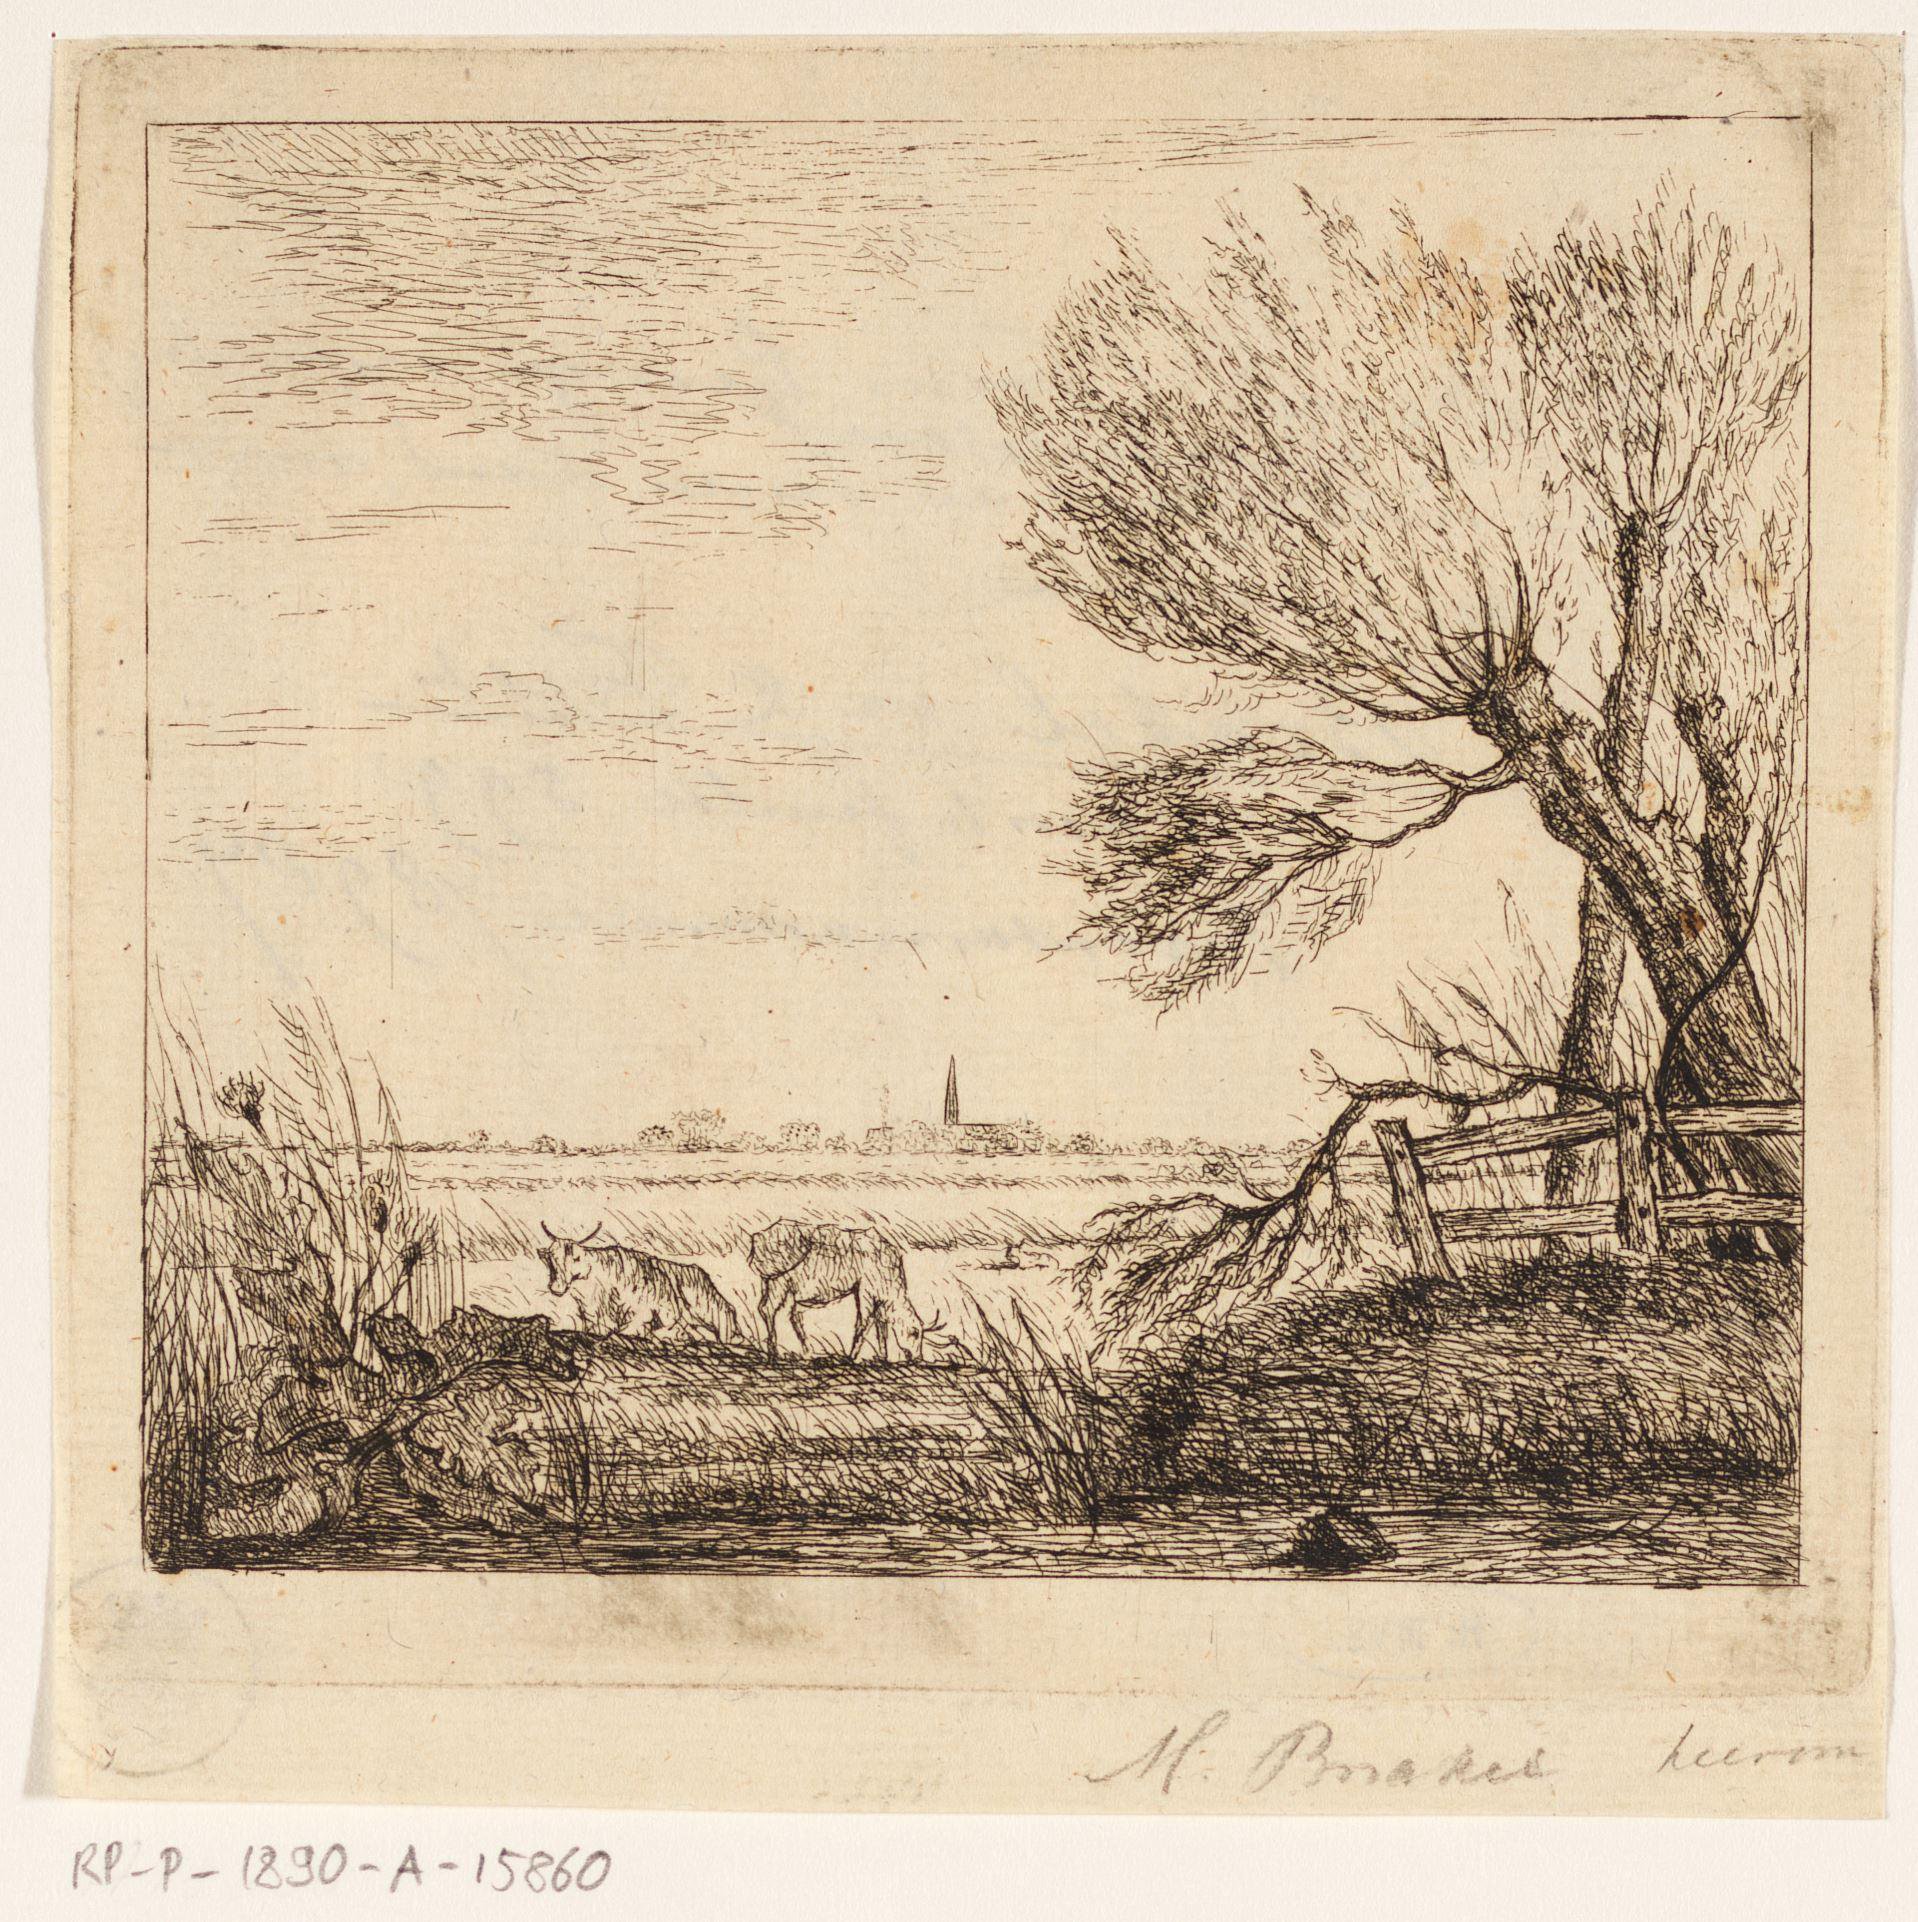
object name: print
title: Weiland met wilgen bij een sloot en twee koeien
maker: m. brakel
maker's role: print maker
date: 1790-1802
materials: paper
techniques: etching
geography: amsterdam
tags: cow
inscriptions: collector's mark: Lugt 514